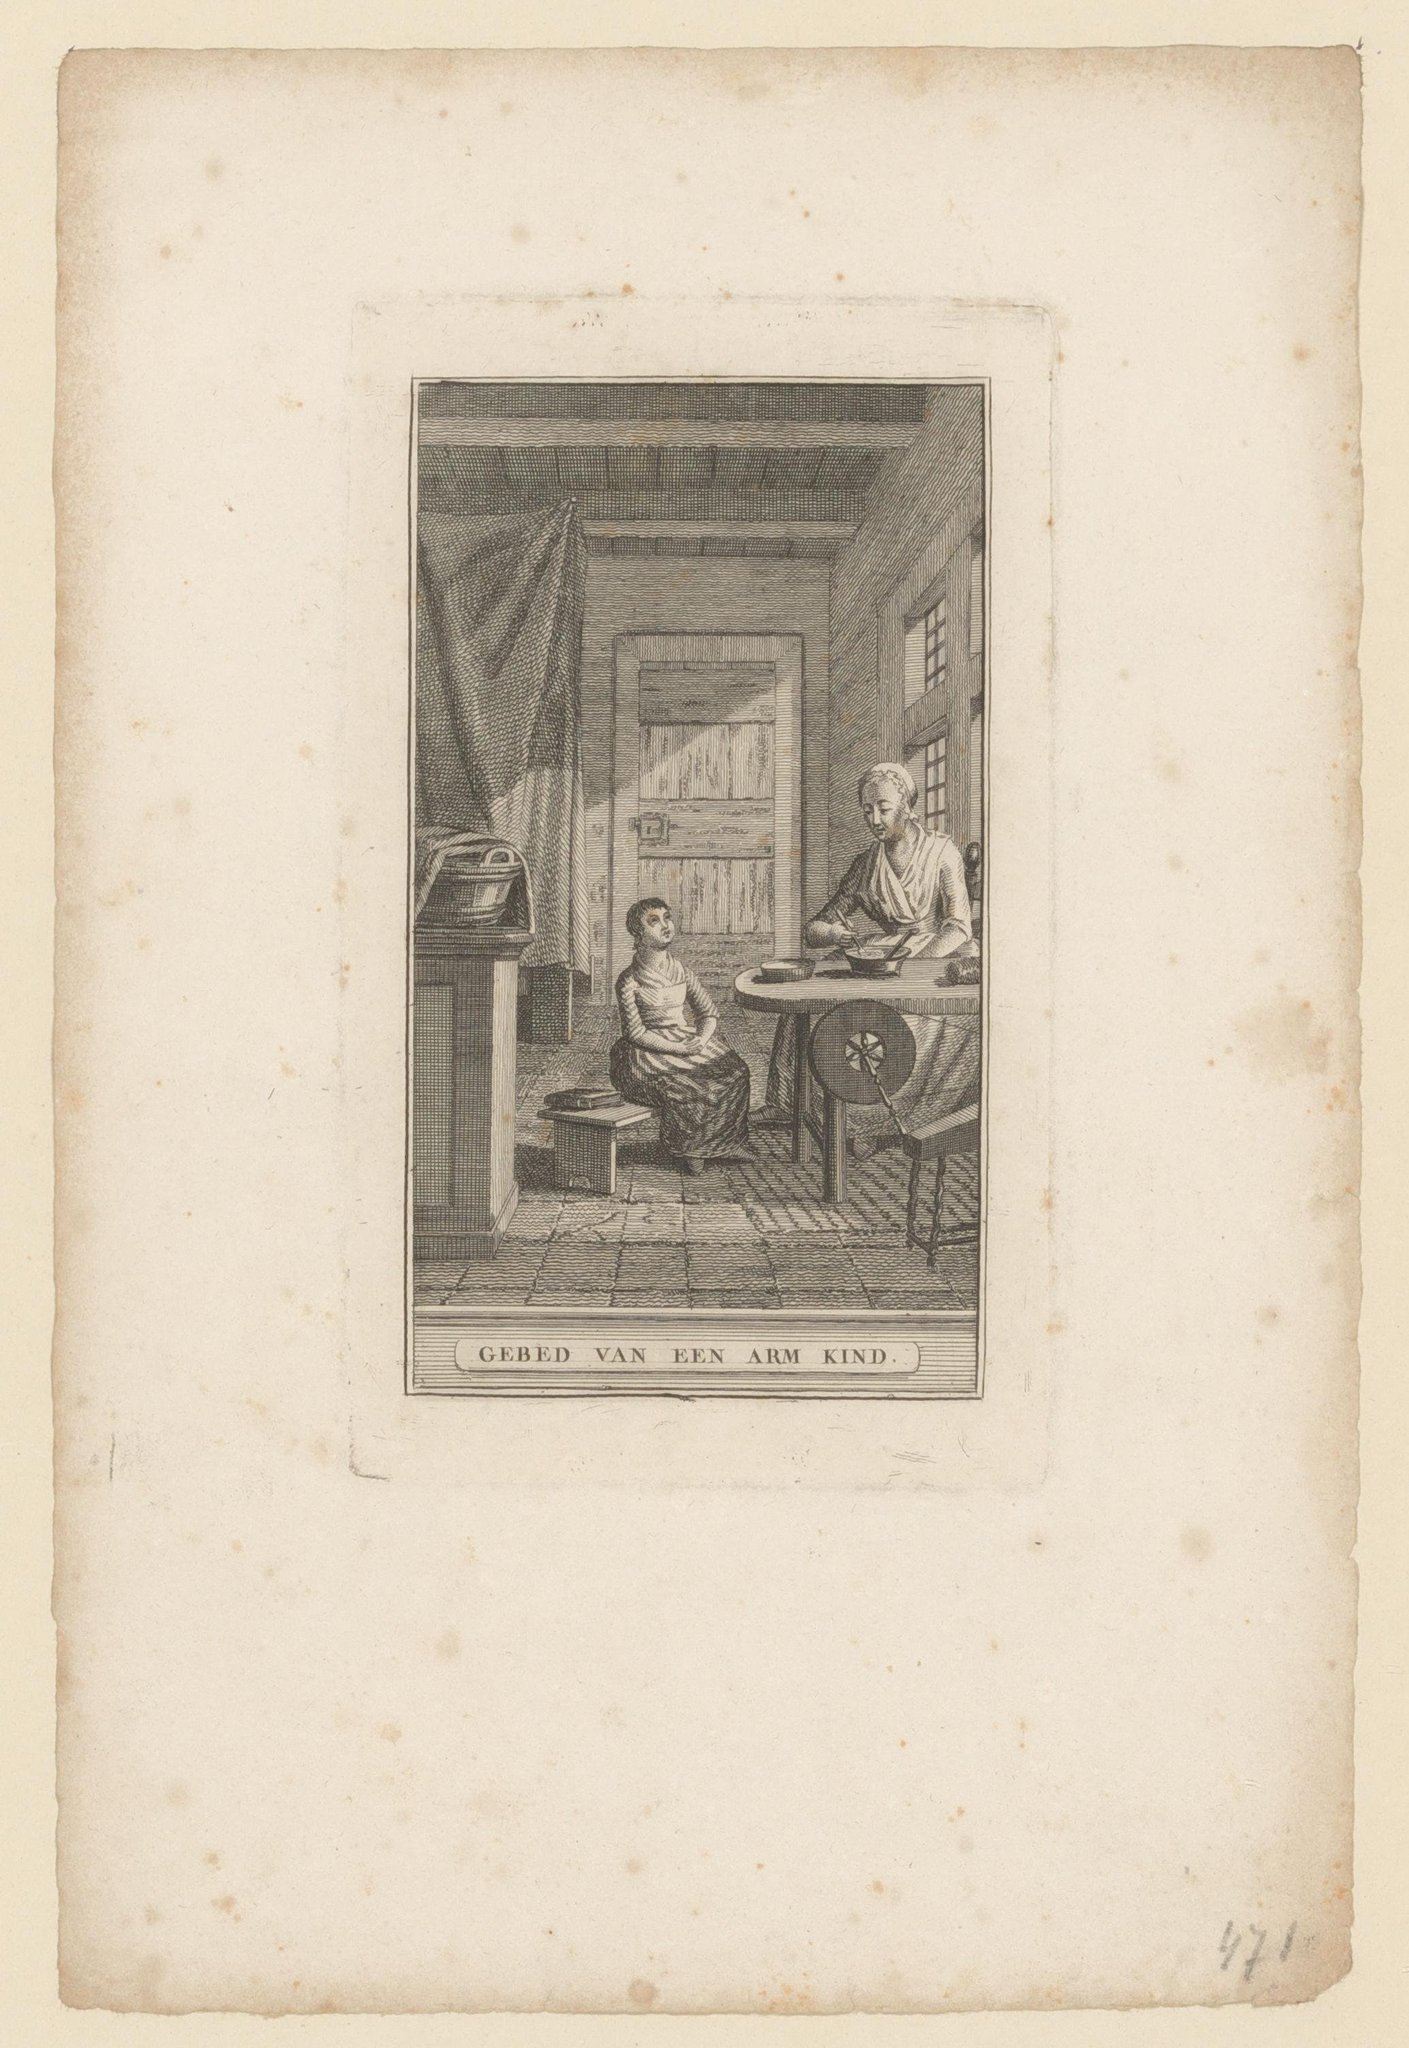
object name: print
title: Biddend kind en een moeder aan tafel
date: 1792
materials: paper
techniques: etching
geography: the hague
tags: mother and baby or young child, one person praying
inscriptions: stamp, collector's mark: Lugt 1641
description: Onderwerpsrubrieken binnen de Atlas Zeden en Gewoonten: Zeden en Gewoonten in Engeren Zin, Des menschen beging, midden en einde, Kinderleven – Kinderspel en Kinderprenten.